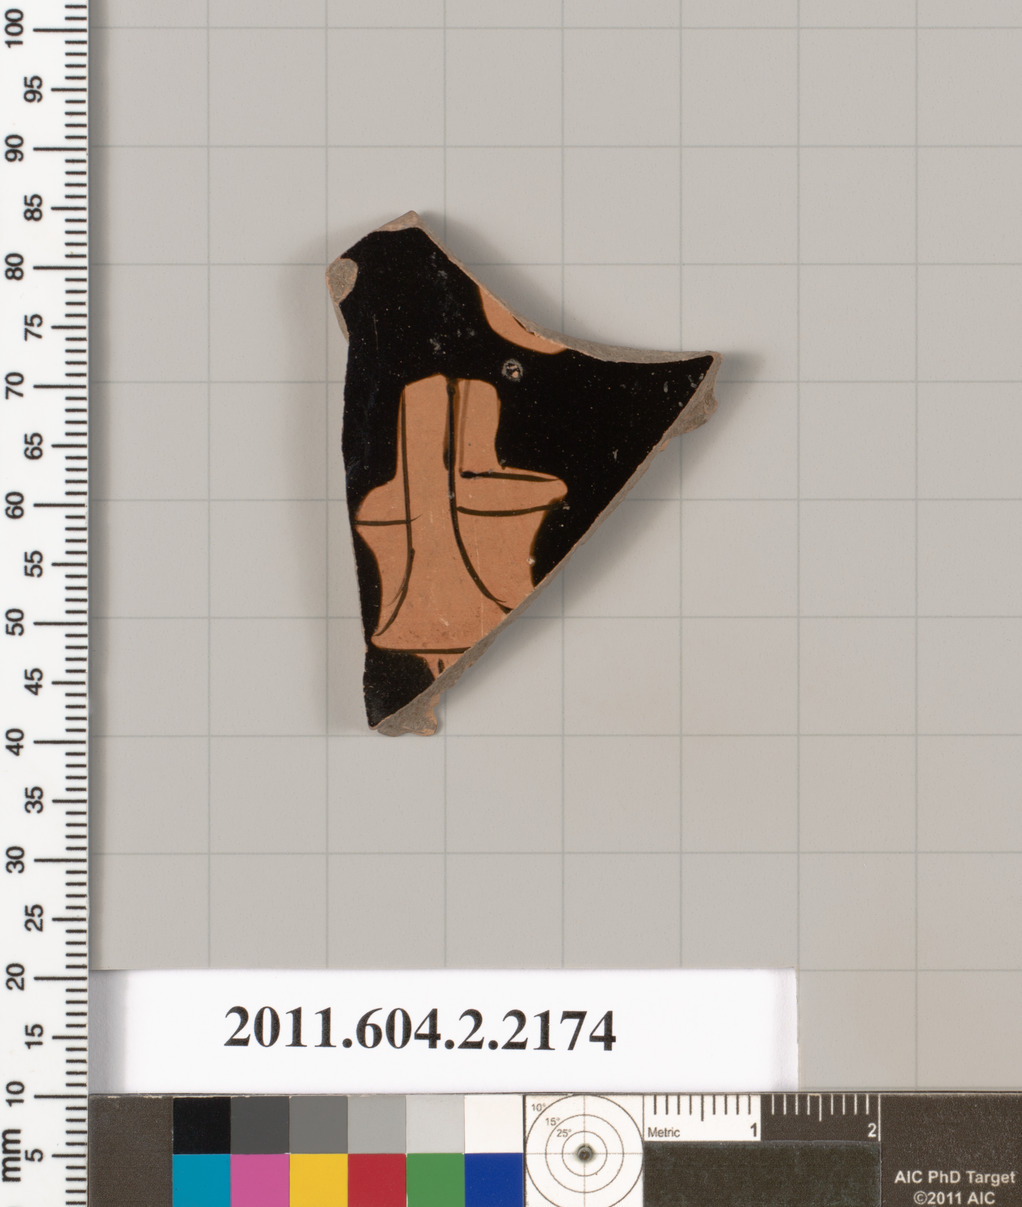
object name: pot fragment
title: Terracotta fragment of a pot; unglazed on the inside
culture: greek, attic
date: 450-426 BCE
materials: terracotta